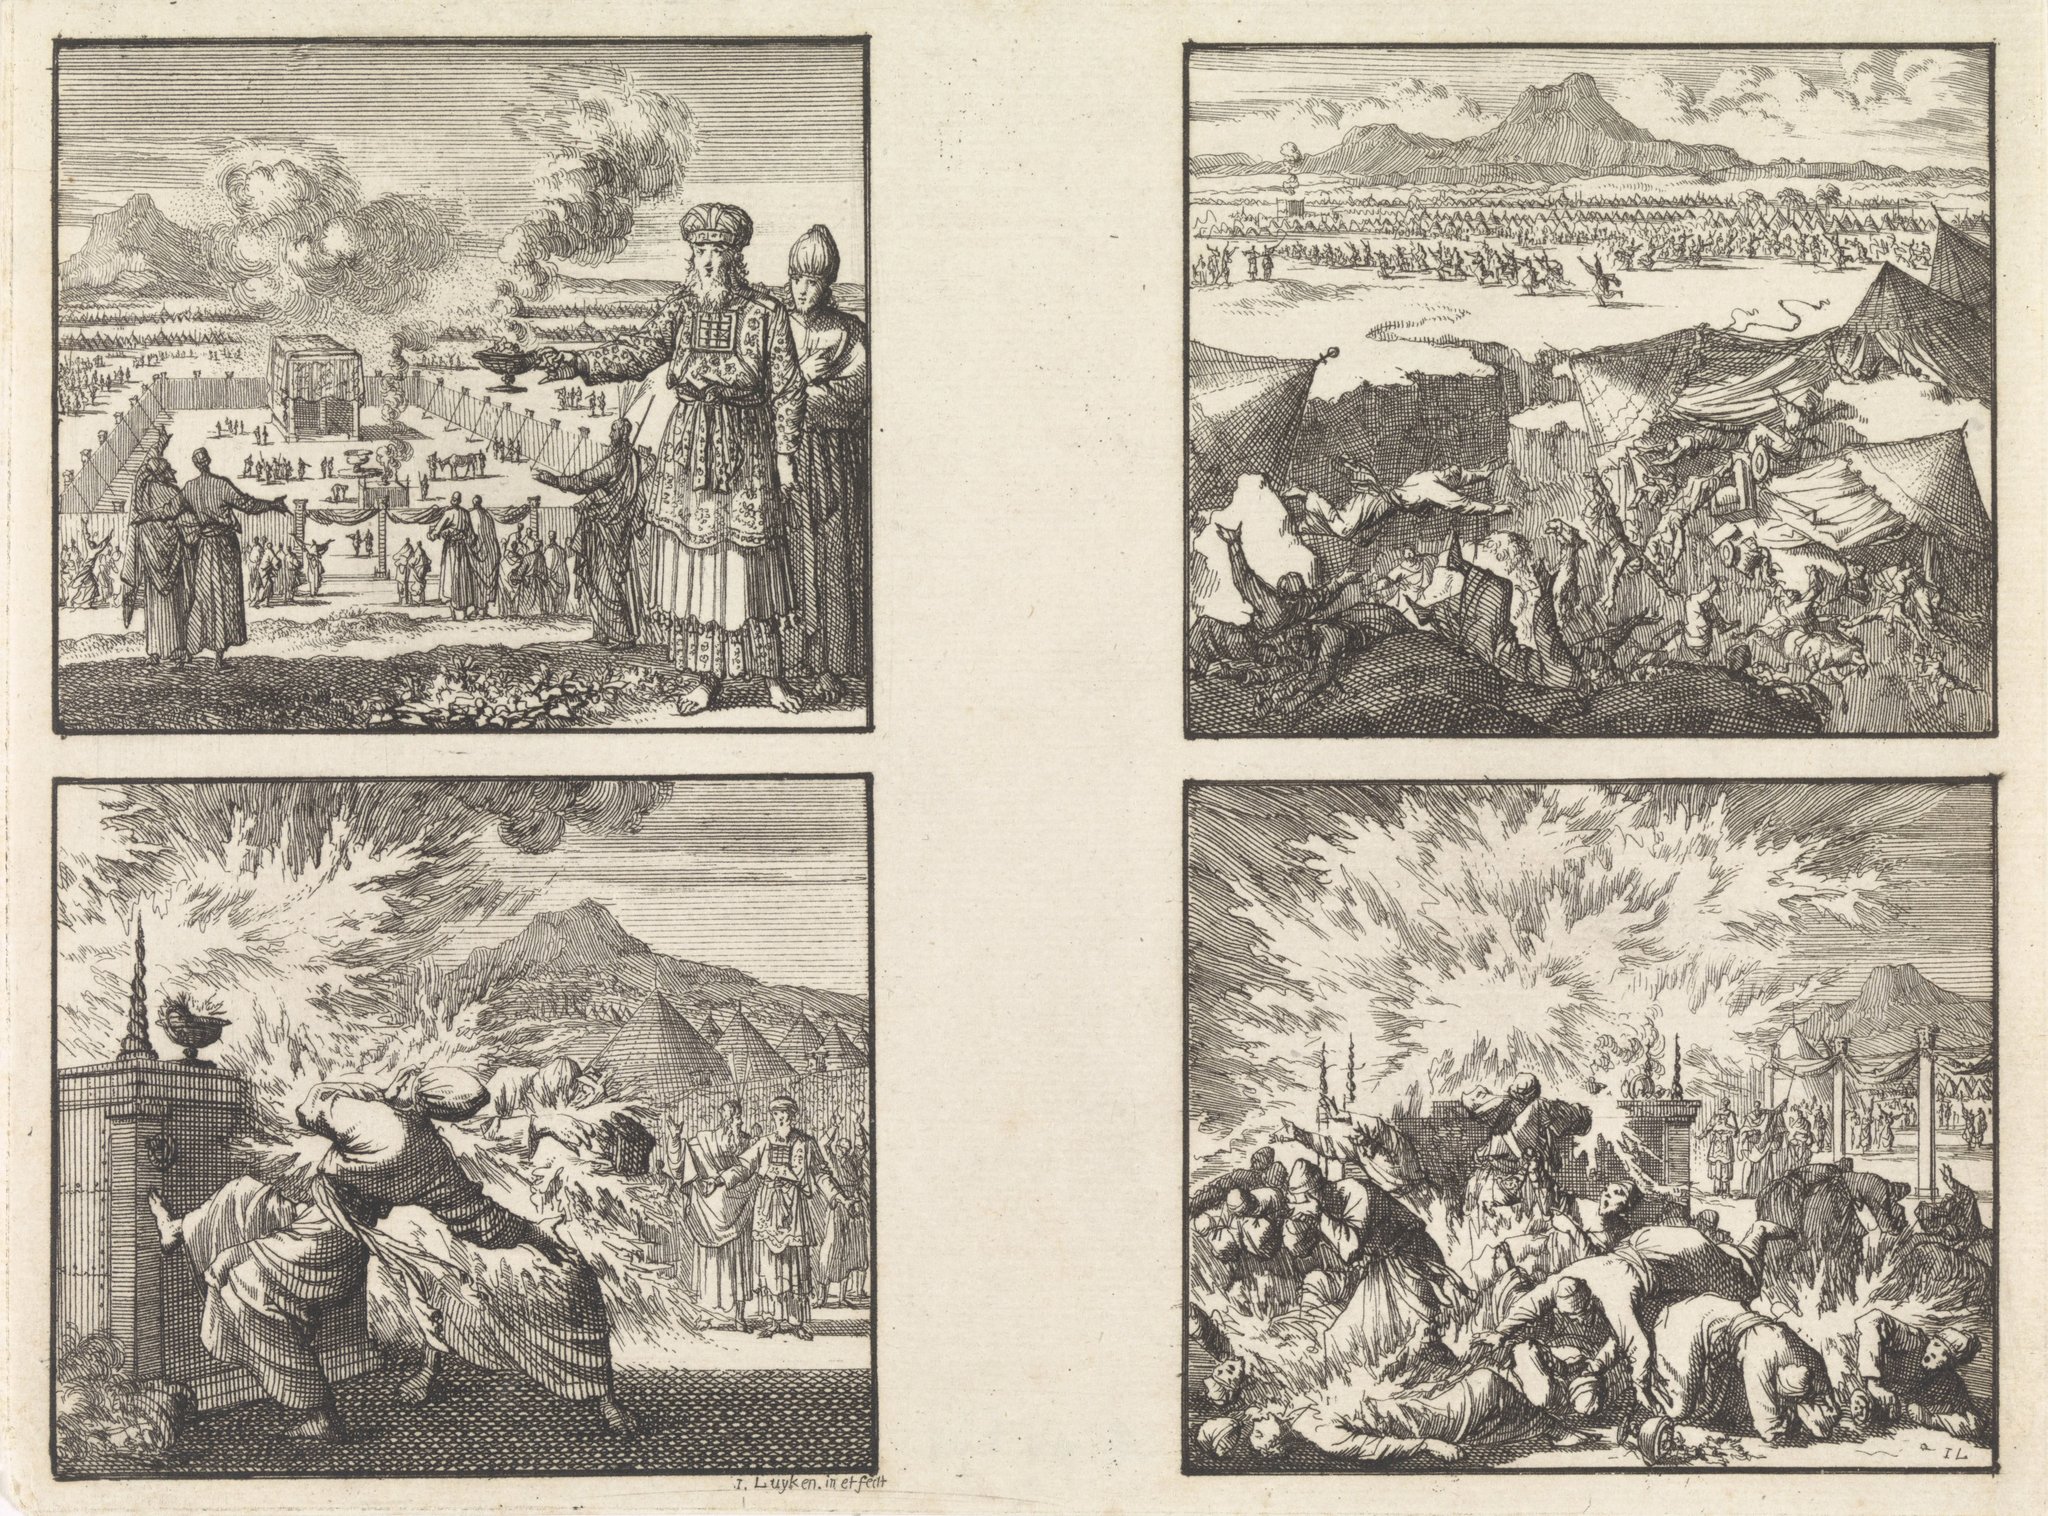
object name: print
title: Aäron als hogepriester / Nadab en Abihu bij het altaar gedood / Datan en Abiram met hun gezinnen door de aarde verzwolgen / Vernietiging van de stam van Korach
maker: jan luyken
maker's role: draughtsman, print maker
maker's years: 1649-1712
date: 1698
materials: paper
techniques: etching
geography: amsterdam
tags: the ground opens and swallows the rebels dathan and abiram along with their families and possessions, two sons of aaron, nadab and abihu, offer incense in their censers to god, who punishes them for this by sending a fire that kills them, rebellion of korah (core), dathan and abiram, and their punishment (numbers 16), aaron (not in biblical context); possible attributes: attributes of aaron: censer, dressed as high priest or bishop, ointment jar, rod or flowering wand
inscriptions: collector's mark: Lugt 2228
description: Proefdruk van illustraties uit: Josephus, Flavius. XX. boeken van de oude geschiedenissen der joden, 4 delen. Amsterdam: Barent Visscher, Willem de Coup, Willem van Lamsveld, Andries van Damme, 1698, dl. I.